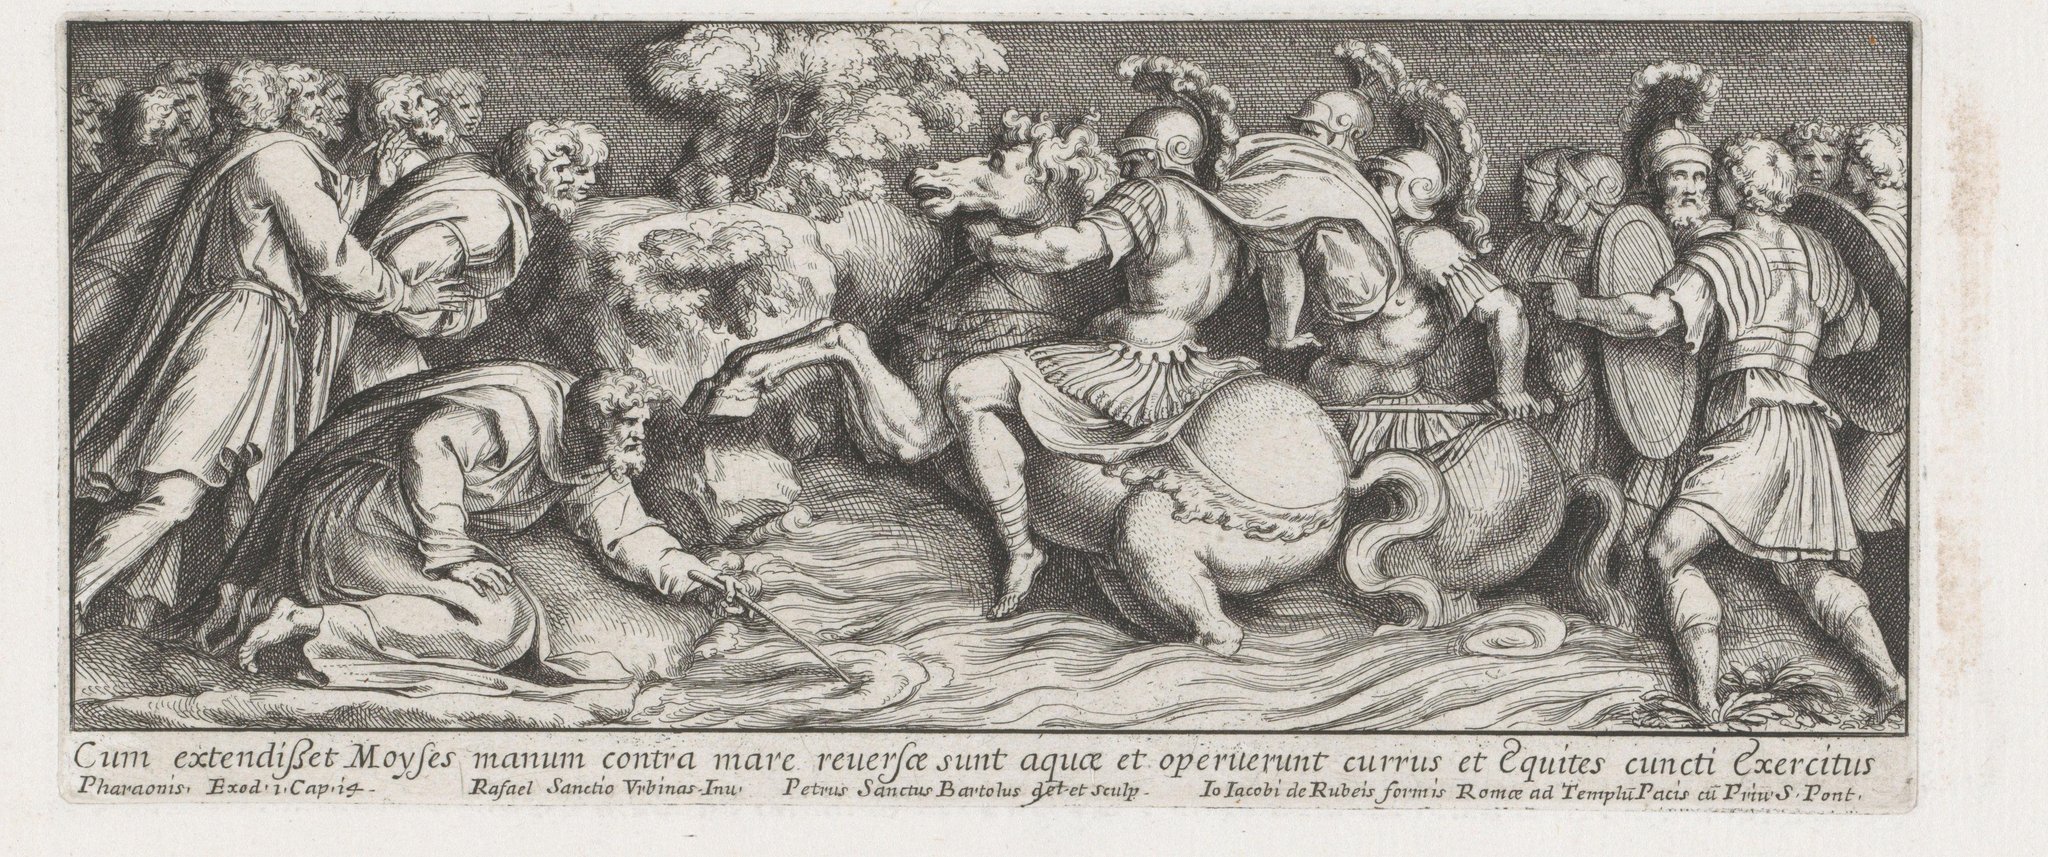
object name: print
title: Voorstellingen door Rafaël in het Vaticaan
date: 1645-1700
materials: paper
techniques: engraving, etching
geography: italy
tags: passage through the red sea, pharaoh and his army engulfed in the red sea (israelites not or barely visible)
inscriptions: collector's mark: Lugt 2228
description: Prent uit een reeks van 14 prenten (+ titelprent) naar schilderingen door Rafaël in de Stanze di Raffaello in het Apostolisch Paleis in het Vaticaan en naar ontwerpen voor wandtapijten voor de Sixtijnse Kapel door Rafaël. Naar een schildering door Rafaël in de Stanza di Eliodoro.